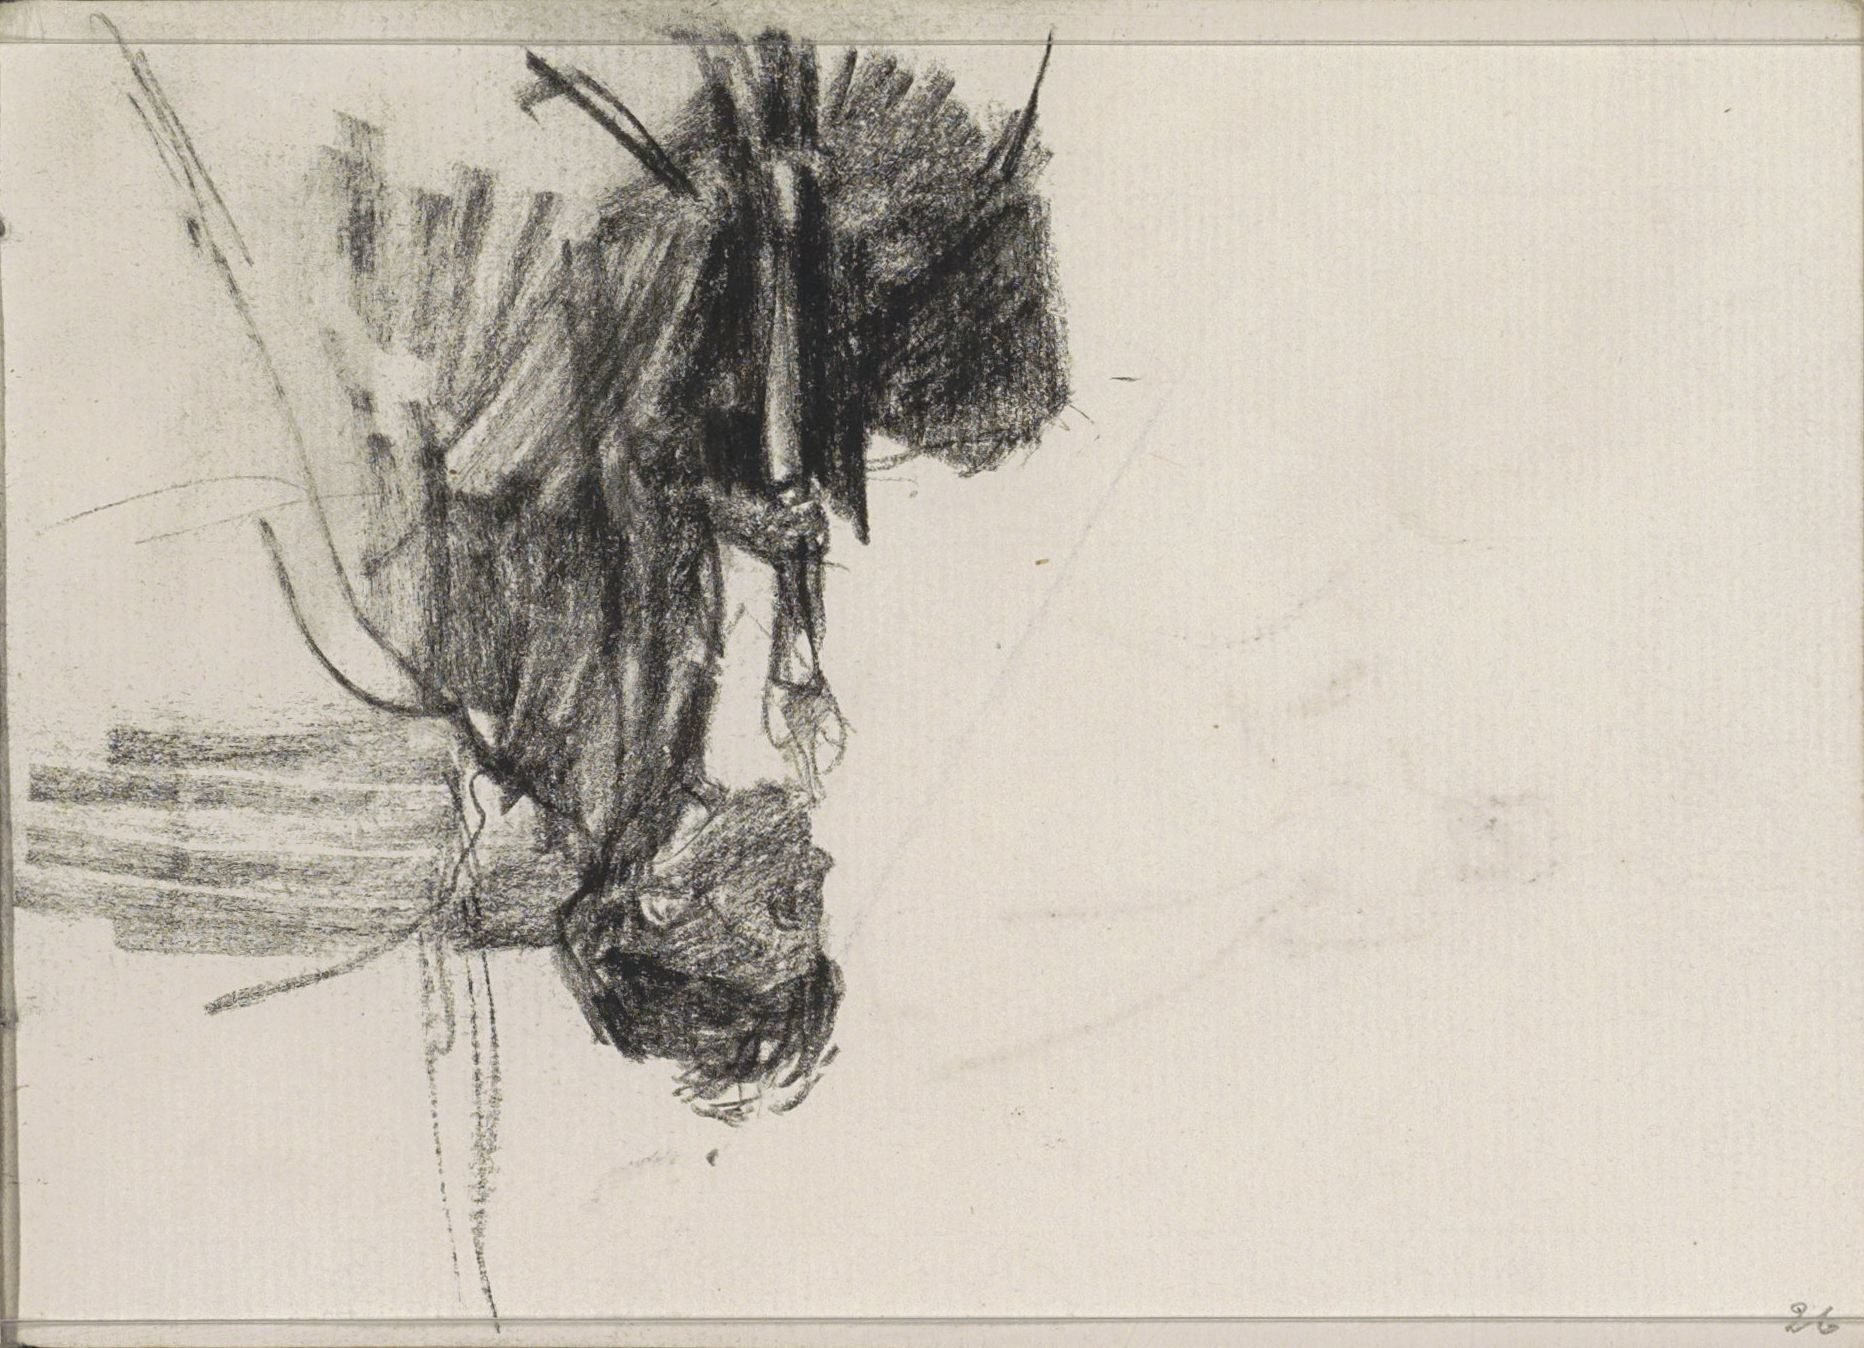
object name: sketchbook leaf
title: Zittende vrouw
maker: isaac israels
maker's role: draughtsman, painter, print maker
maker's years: 1865-1934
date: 1875-1934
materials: chalk, paper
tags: adult woman (+ sitting)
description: Ze heeft een voorwerp in haar handen. Blad 26 recto uit schetsboek LVI met 26 bladen.